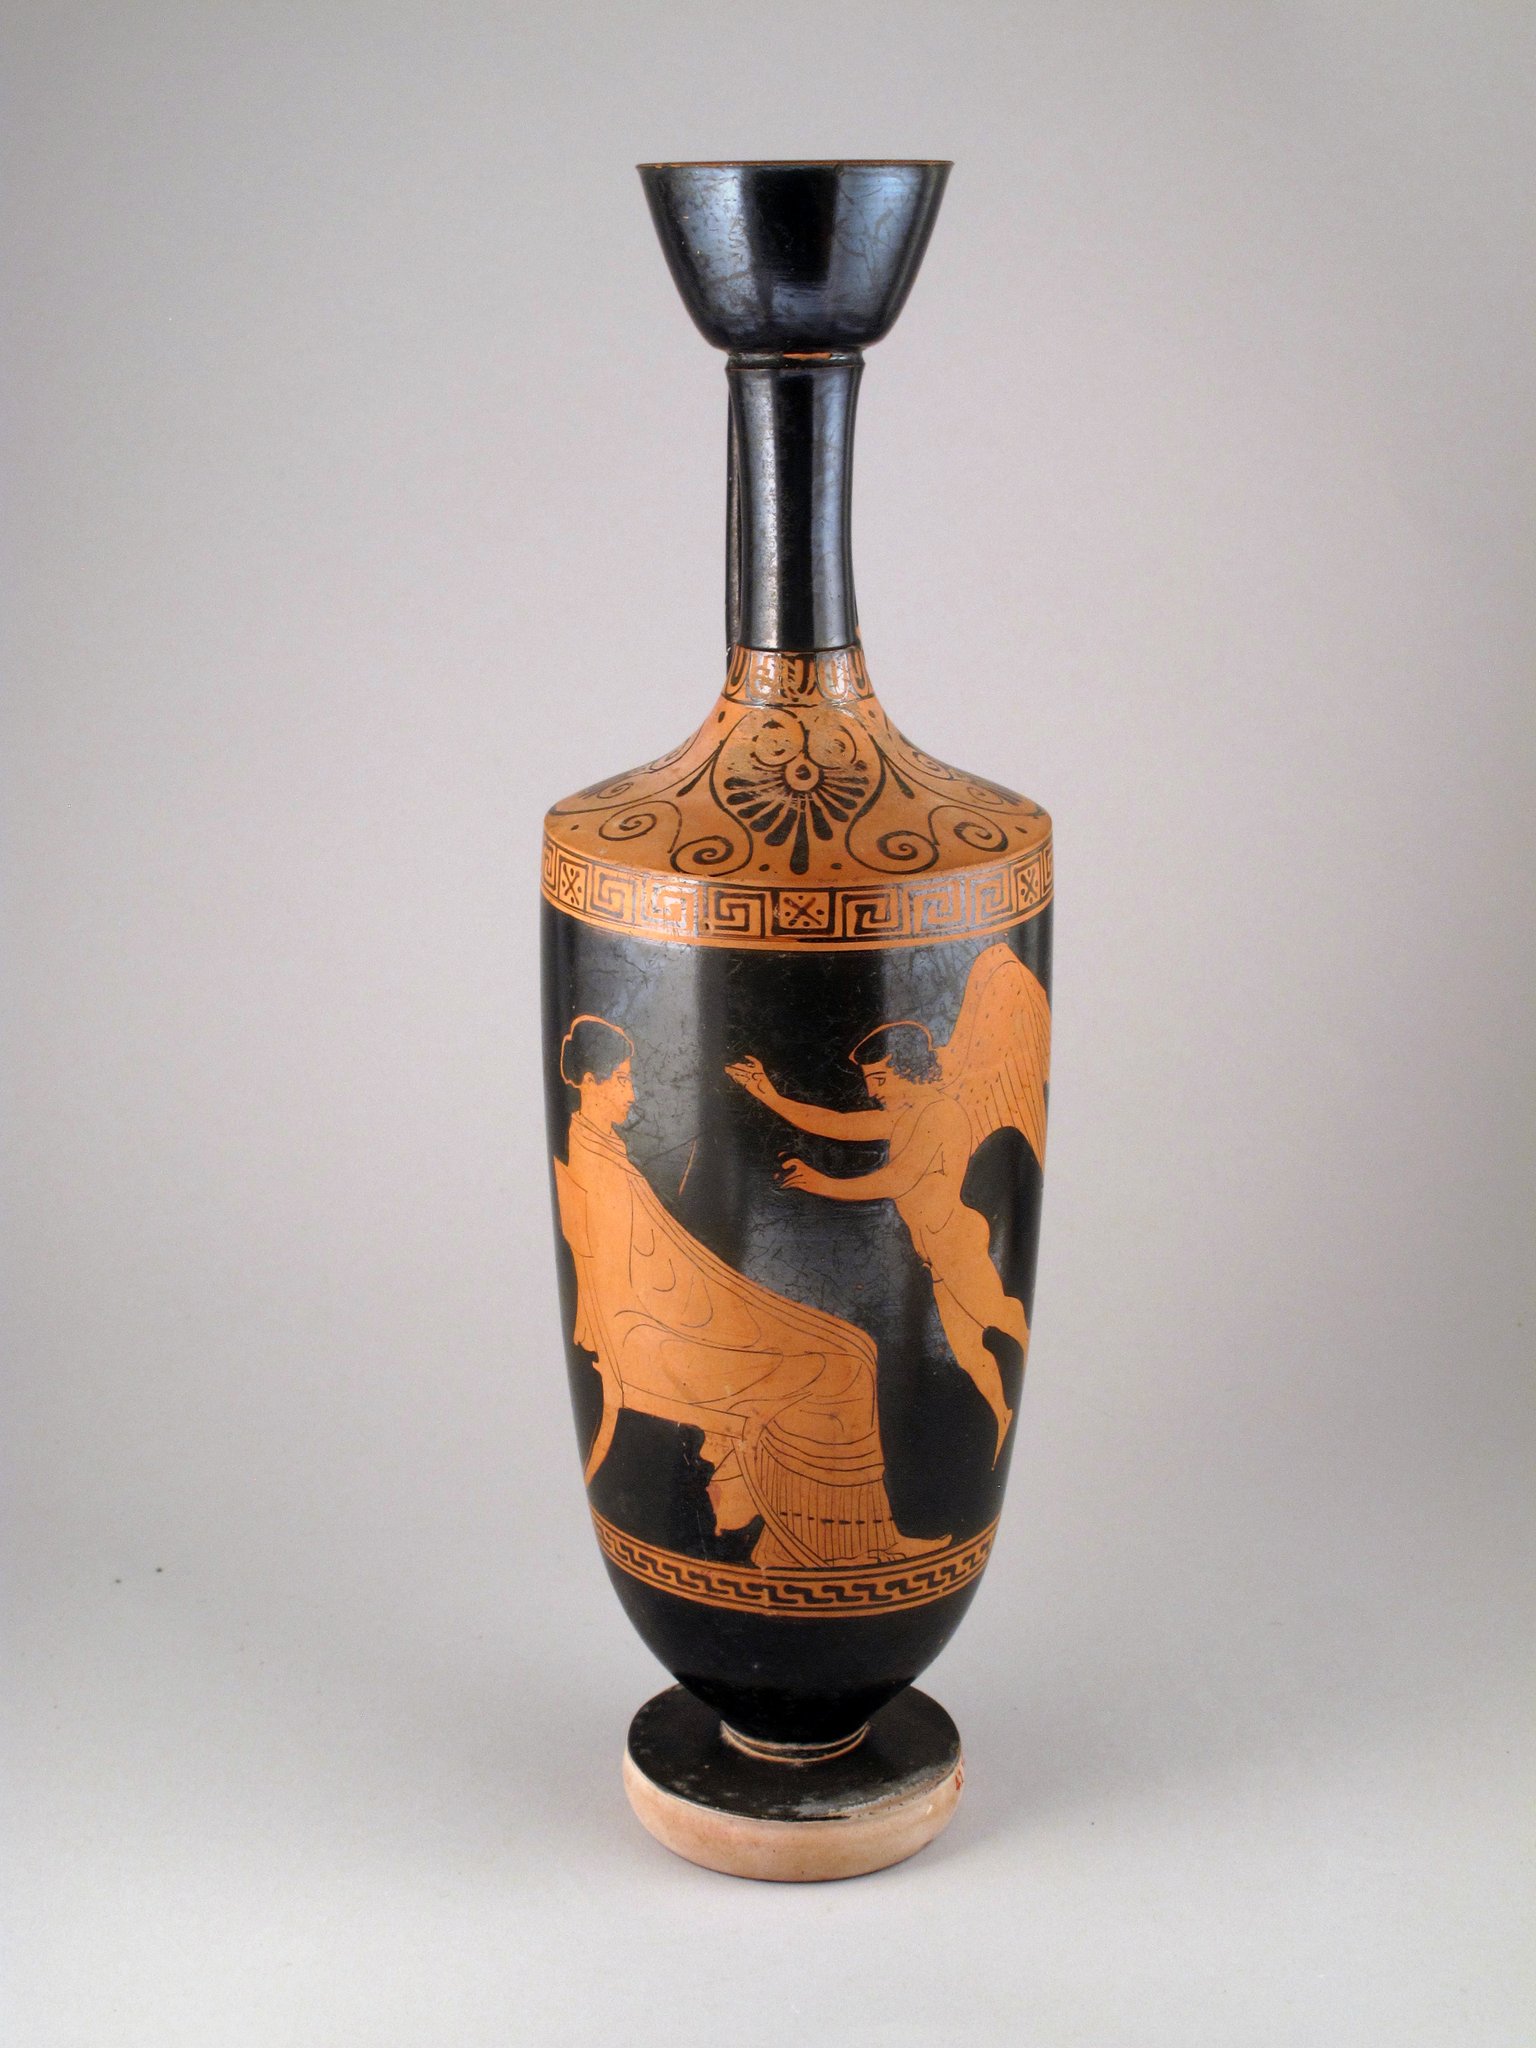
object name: lekythos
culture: greek, attic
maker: group of naples stg. 252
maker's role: artist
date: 440 BCE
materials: terracotta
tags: women,eros